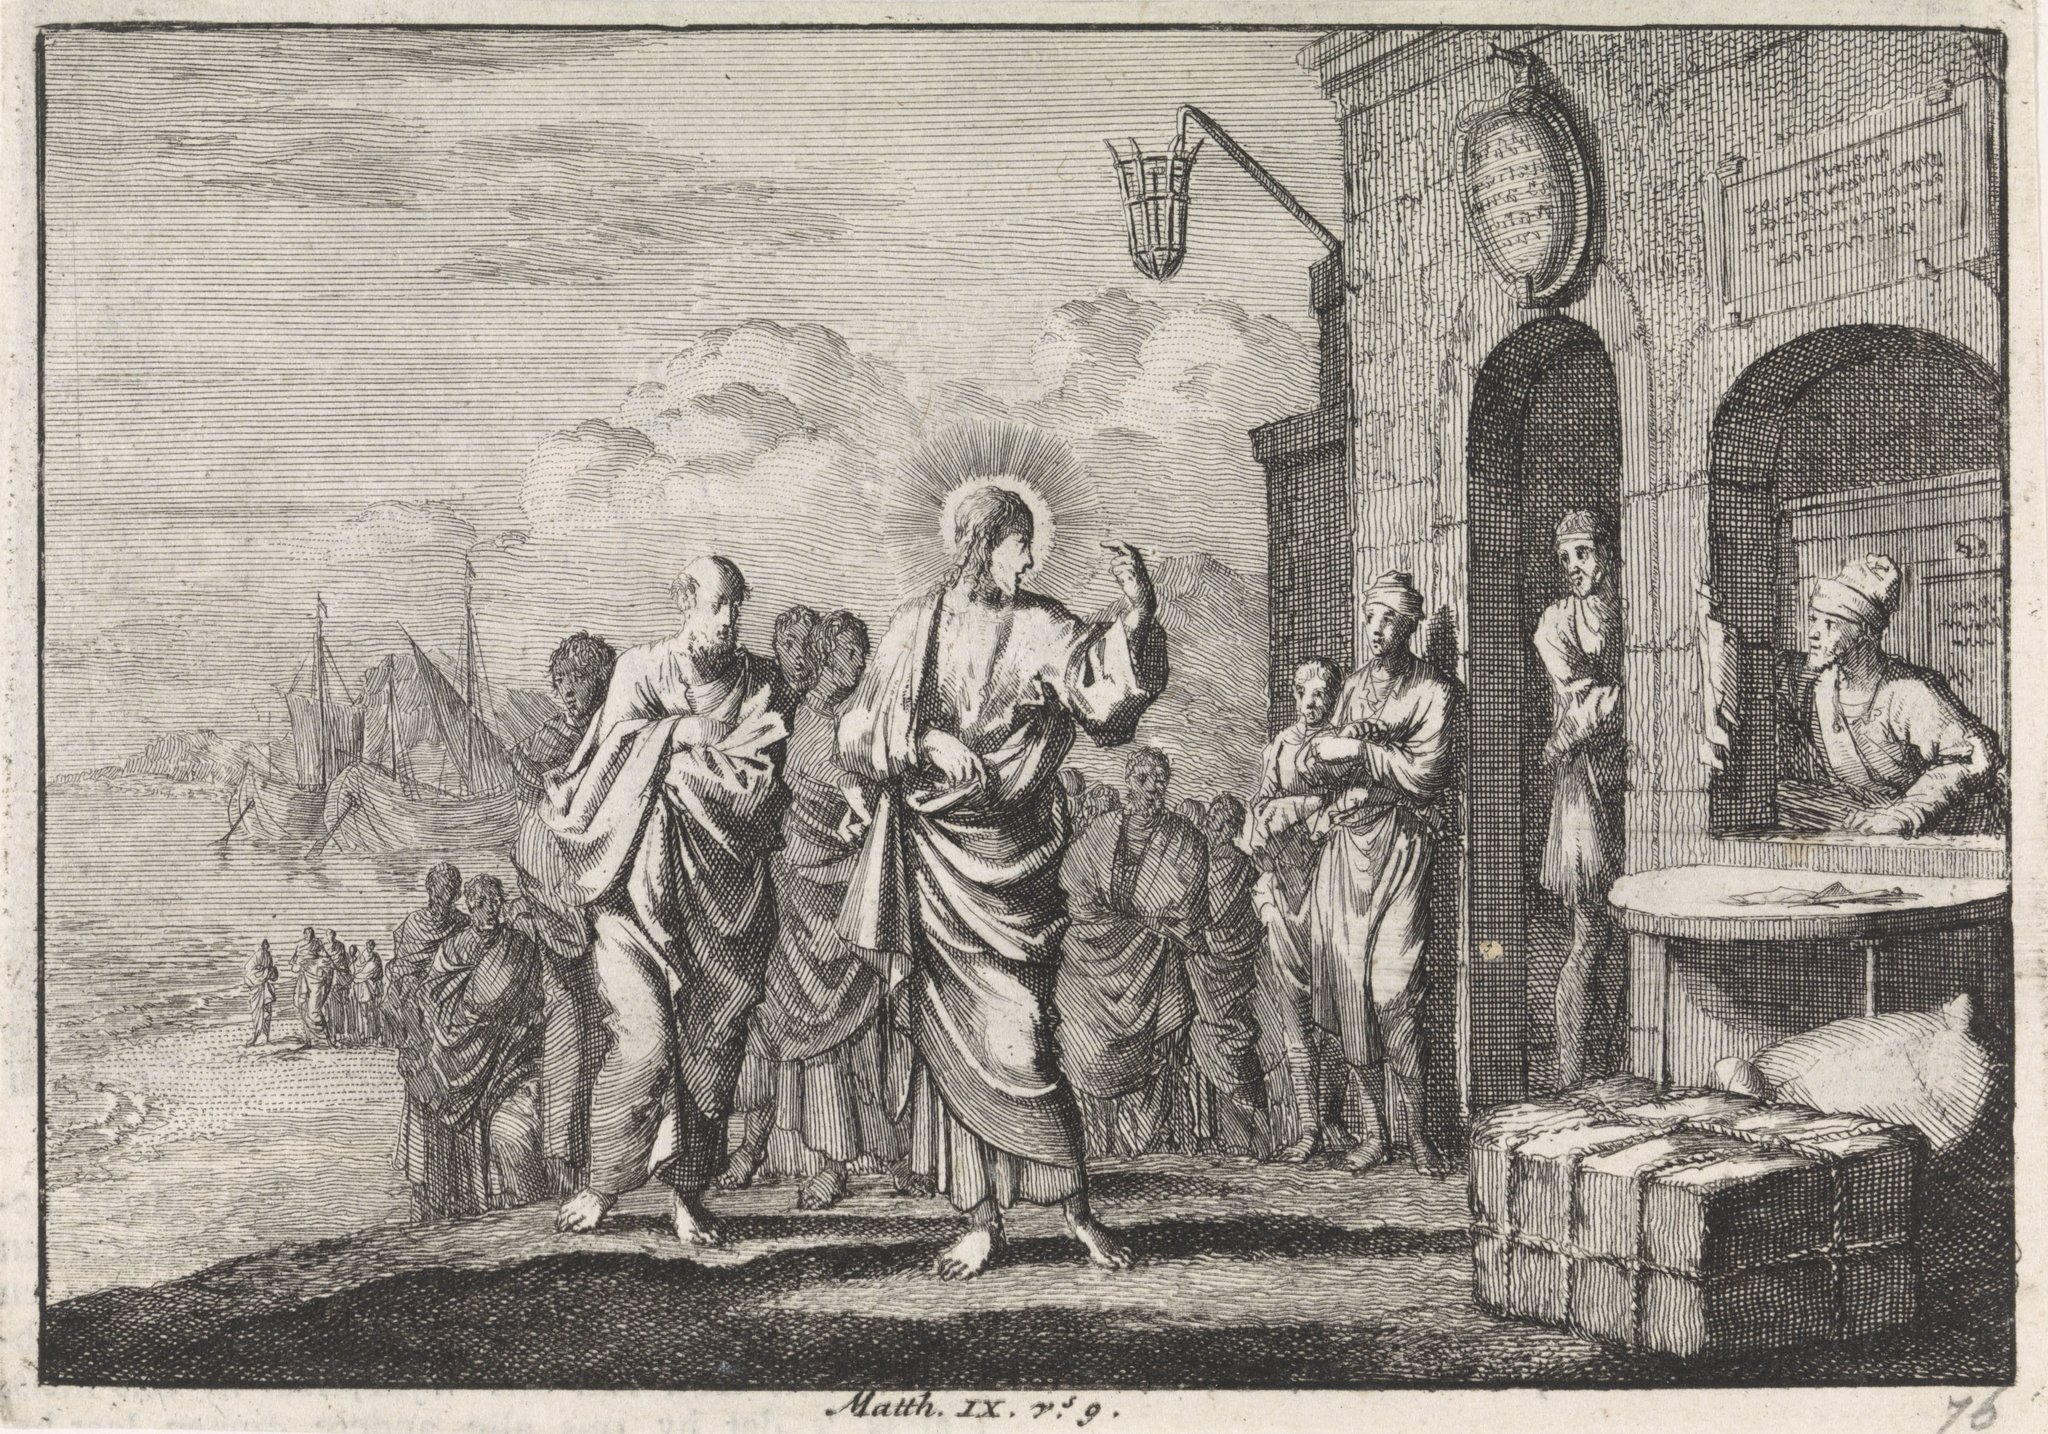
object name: book illustration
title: Roeping van Matteüs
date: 1703-1762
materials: paper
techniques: etching, letterpress printing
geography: amsterdam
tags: calling of matthew (levi), the tax-collector (usually with money lying on the table and people paying taxes) (matthew 9:9; mark 2:14; luke 5:27-28)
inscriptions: collector's mark: Lugt 2228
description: De prent komt een eerste keer voor als boekillustratie voor David Martin. Historie des Ouden en Nieuwen Testaments. Amsterdam, Pieter Mortier, 1703. Deel II. De boekillustraties voor de Mortierbijbel hebben verschillende staten en kopieën, waarbij de chronologische volgorde moeilijk te achterhalen valt. Als boekillustraties werden ze bovendien herhaaldelijk opnieuw gebruikt voor andere boekwerken.